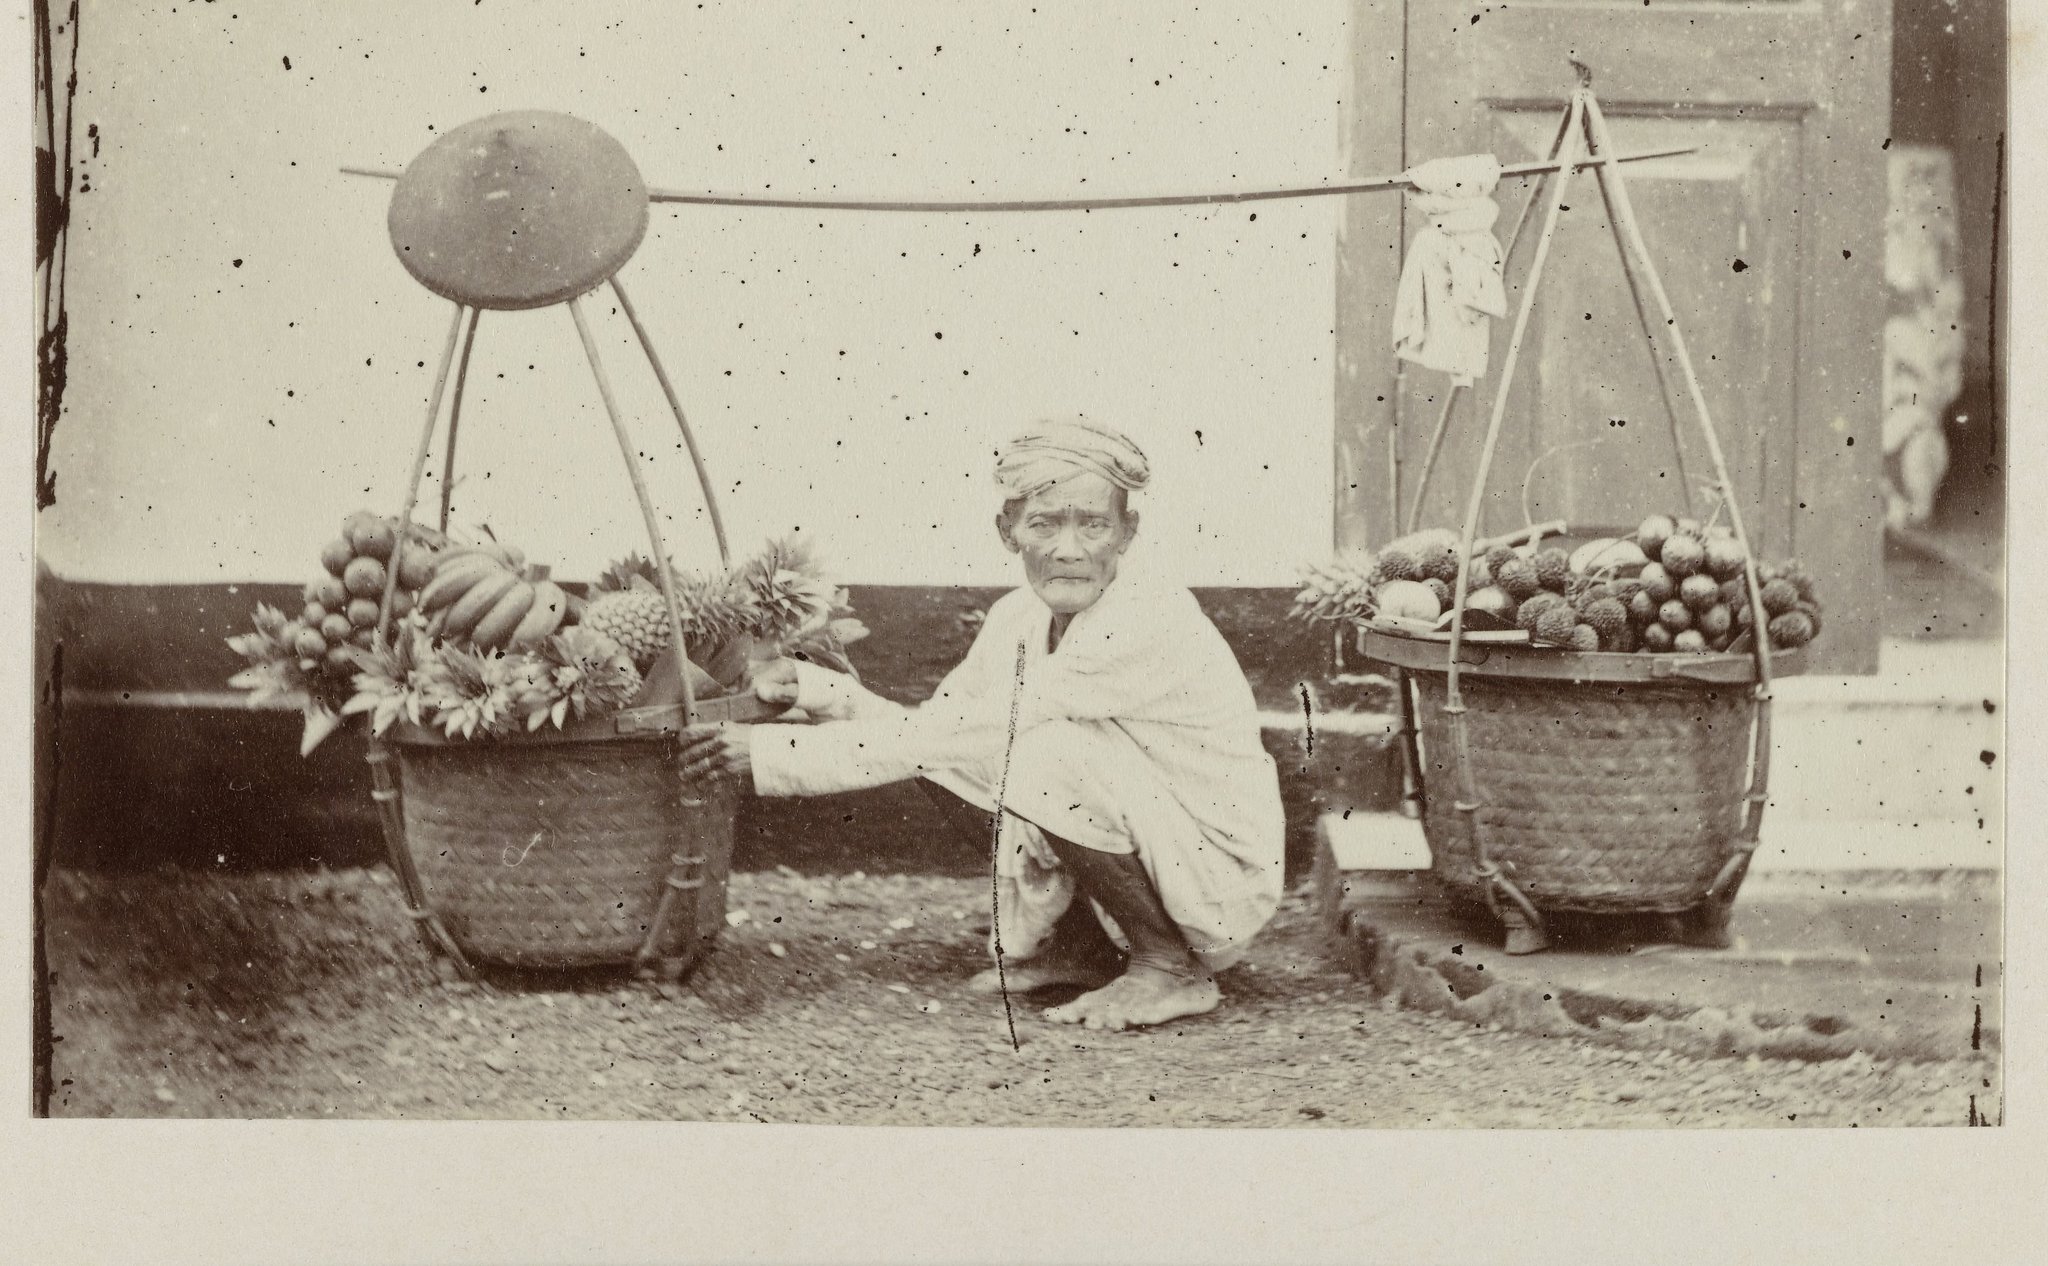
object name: photograph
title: Javaanse drager met vruchten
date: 1860-1880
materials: photographic support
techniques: albumen print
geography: batavia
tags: carrying something with carrying-pole, fruit, java, batavia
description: Een Javaanse drager met vruchten, fruitverkoper, hurkend op straat, op Java. Ingeplakte foto in het fotoalbum getiteld: Gezichten van Java.